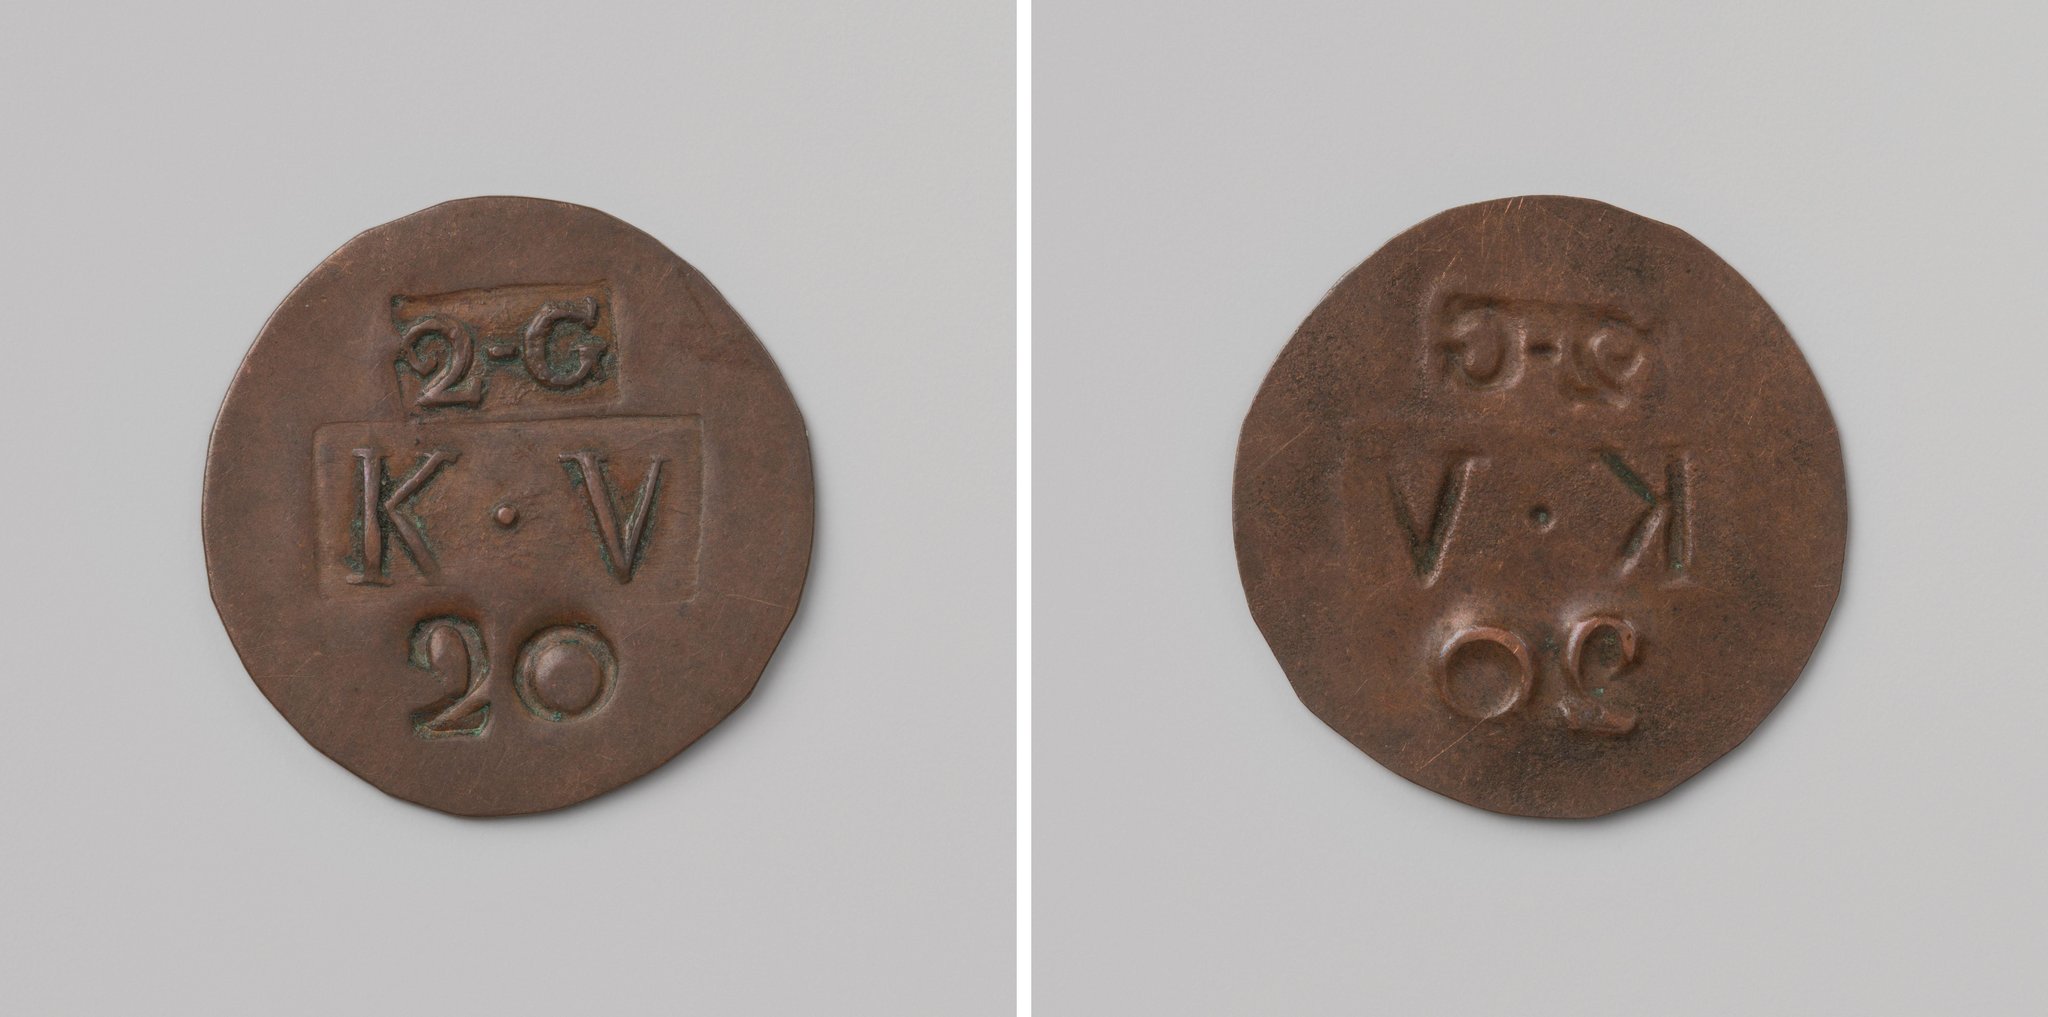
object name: monetary token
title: Tweede gesticht van de kolonie Veenhuizen, huismunt van twintig cent, geslagen op last van de Maatschappij van Weldadigheid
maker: Anonymous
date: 1818-1859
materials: copper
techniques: striking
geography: netherlands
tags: maatschappij van weldadigheid, veenhuizen